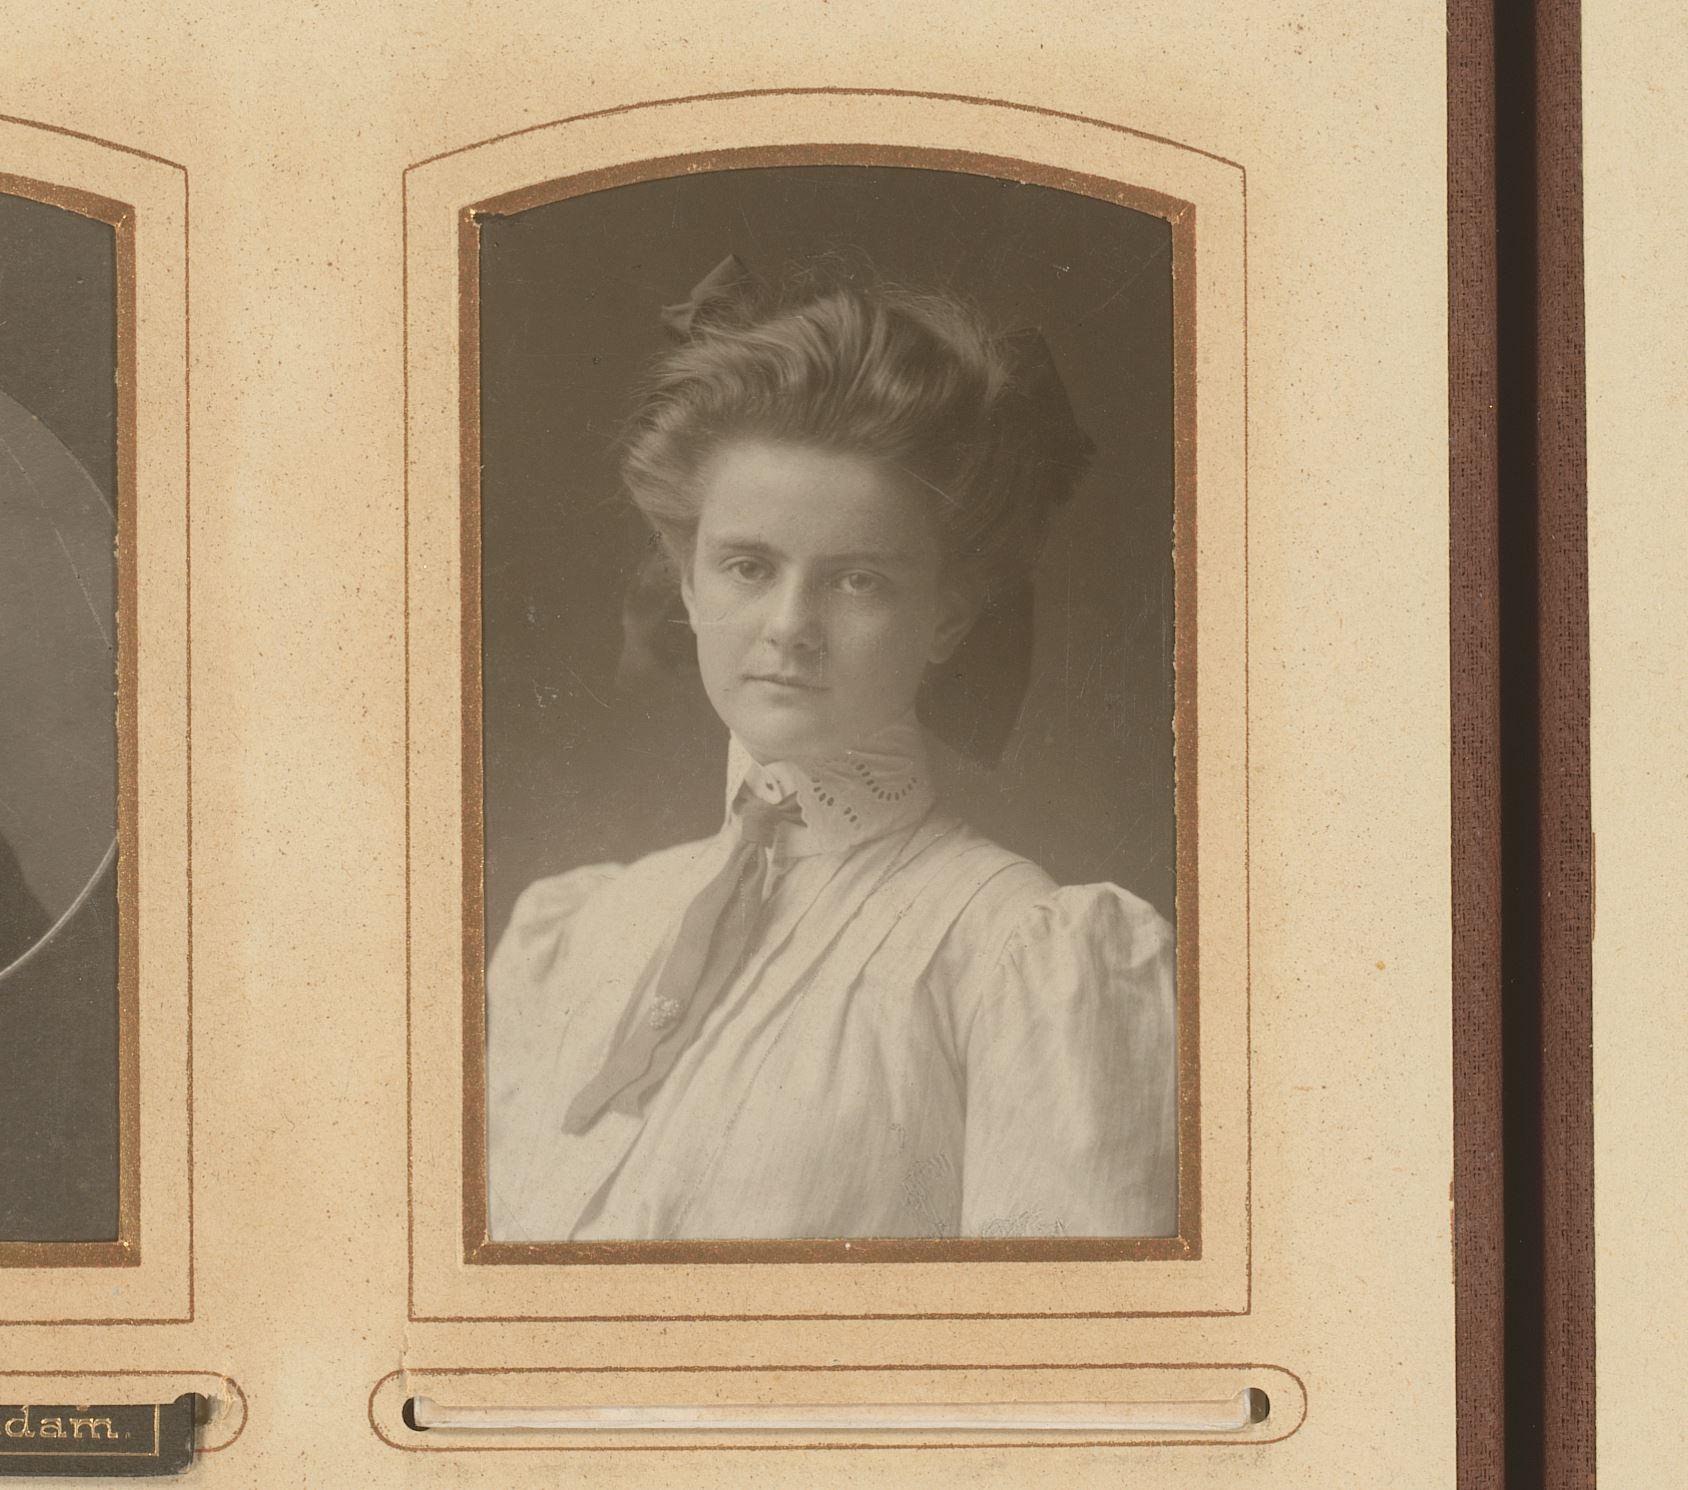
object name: album leaf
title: Portret van een jonge vrouw, aangeduid als Alida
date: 1907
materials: cardboard, photographic support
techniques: collodion silver print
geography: haarlem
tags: adolescent, young woman, maiden, historical persons - bb - woman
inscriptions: inscription: ‘Bakken en Slier/ Gr. Houtstraat 92/ Haarlem’, annotation: ‘19 Nov. 1907/ Alida [...]’